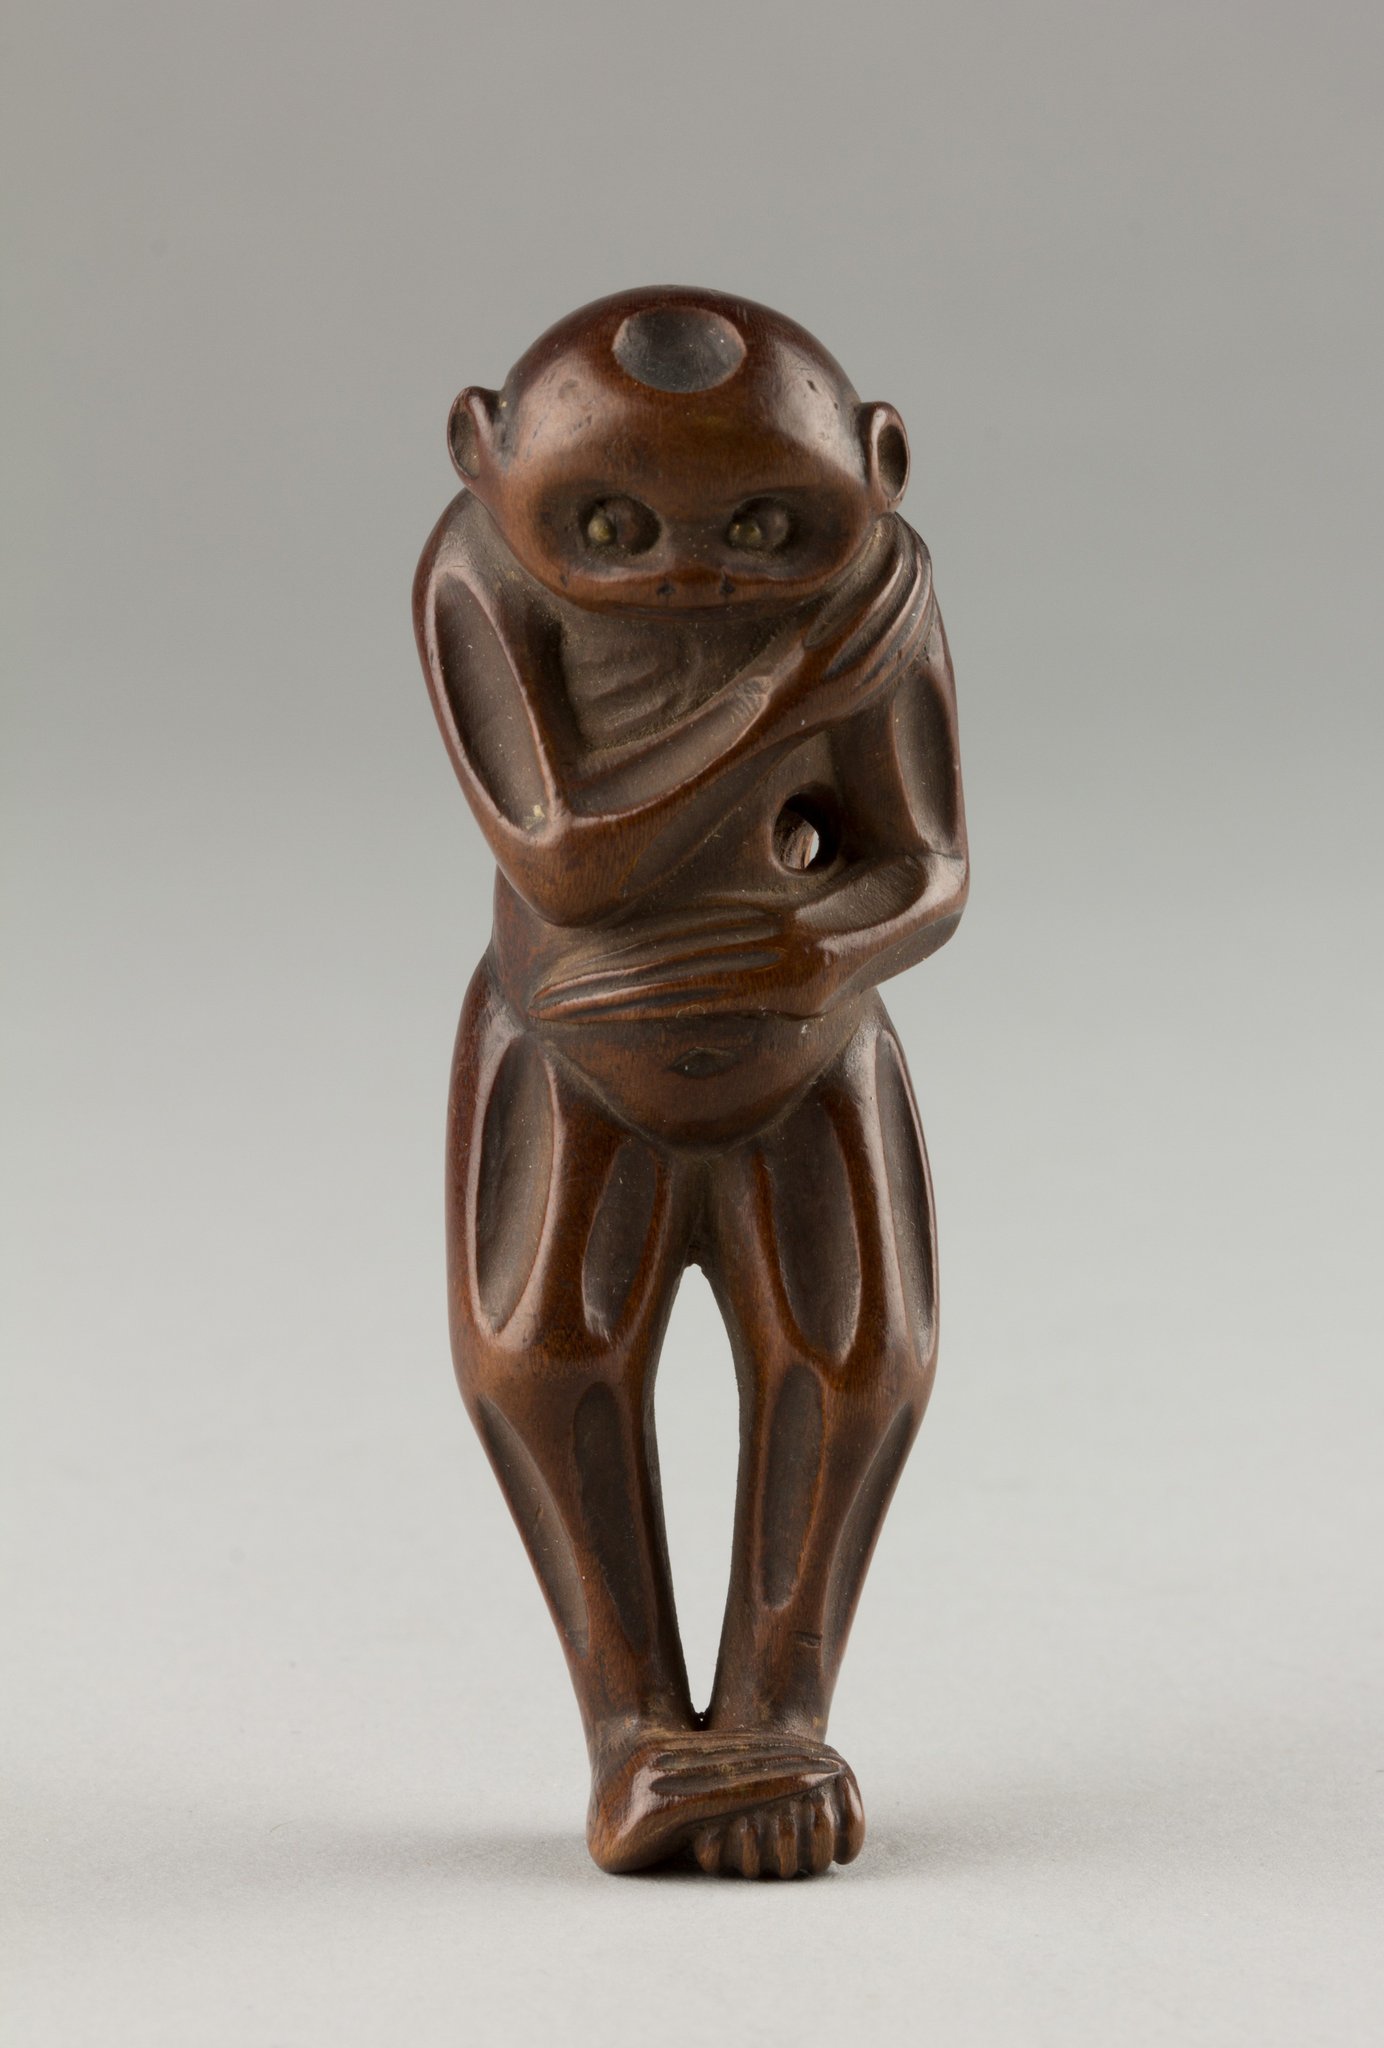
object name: netsuke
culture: japanese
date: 1701-1800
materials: wood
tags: human figures